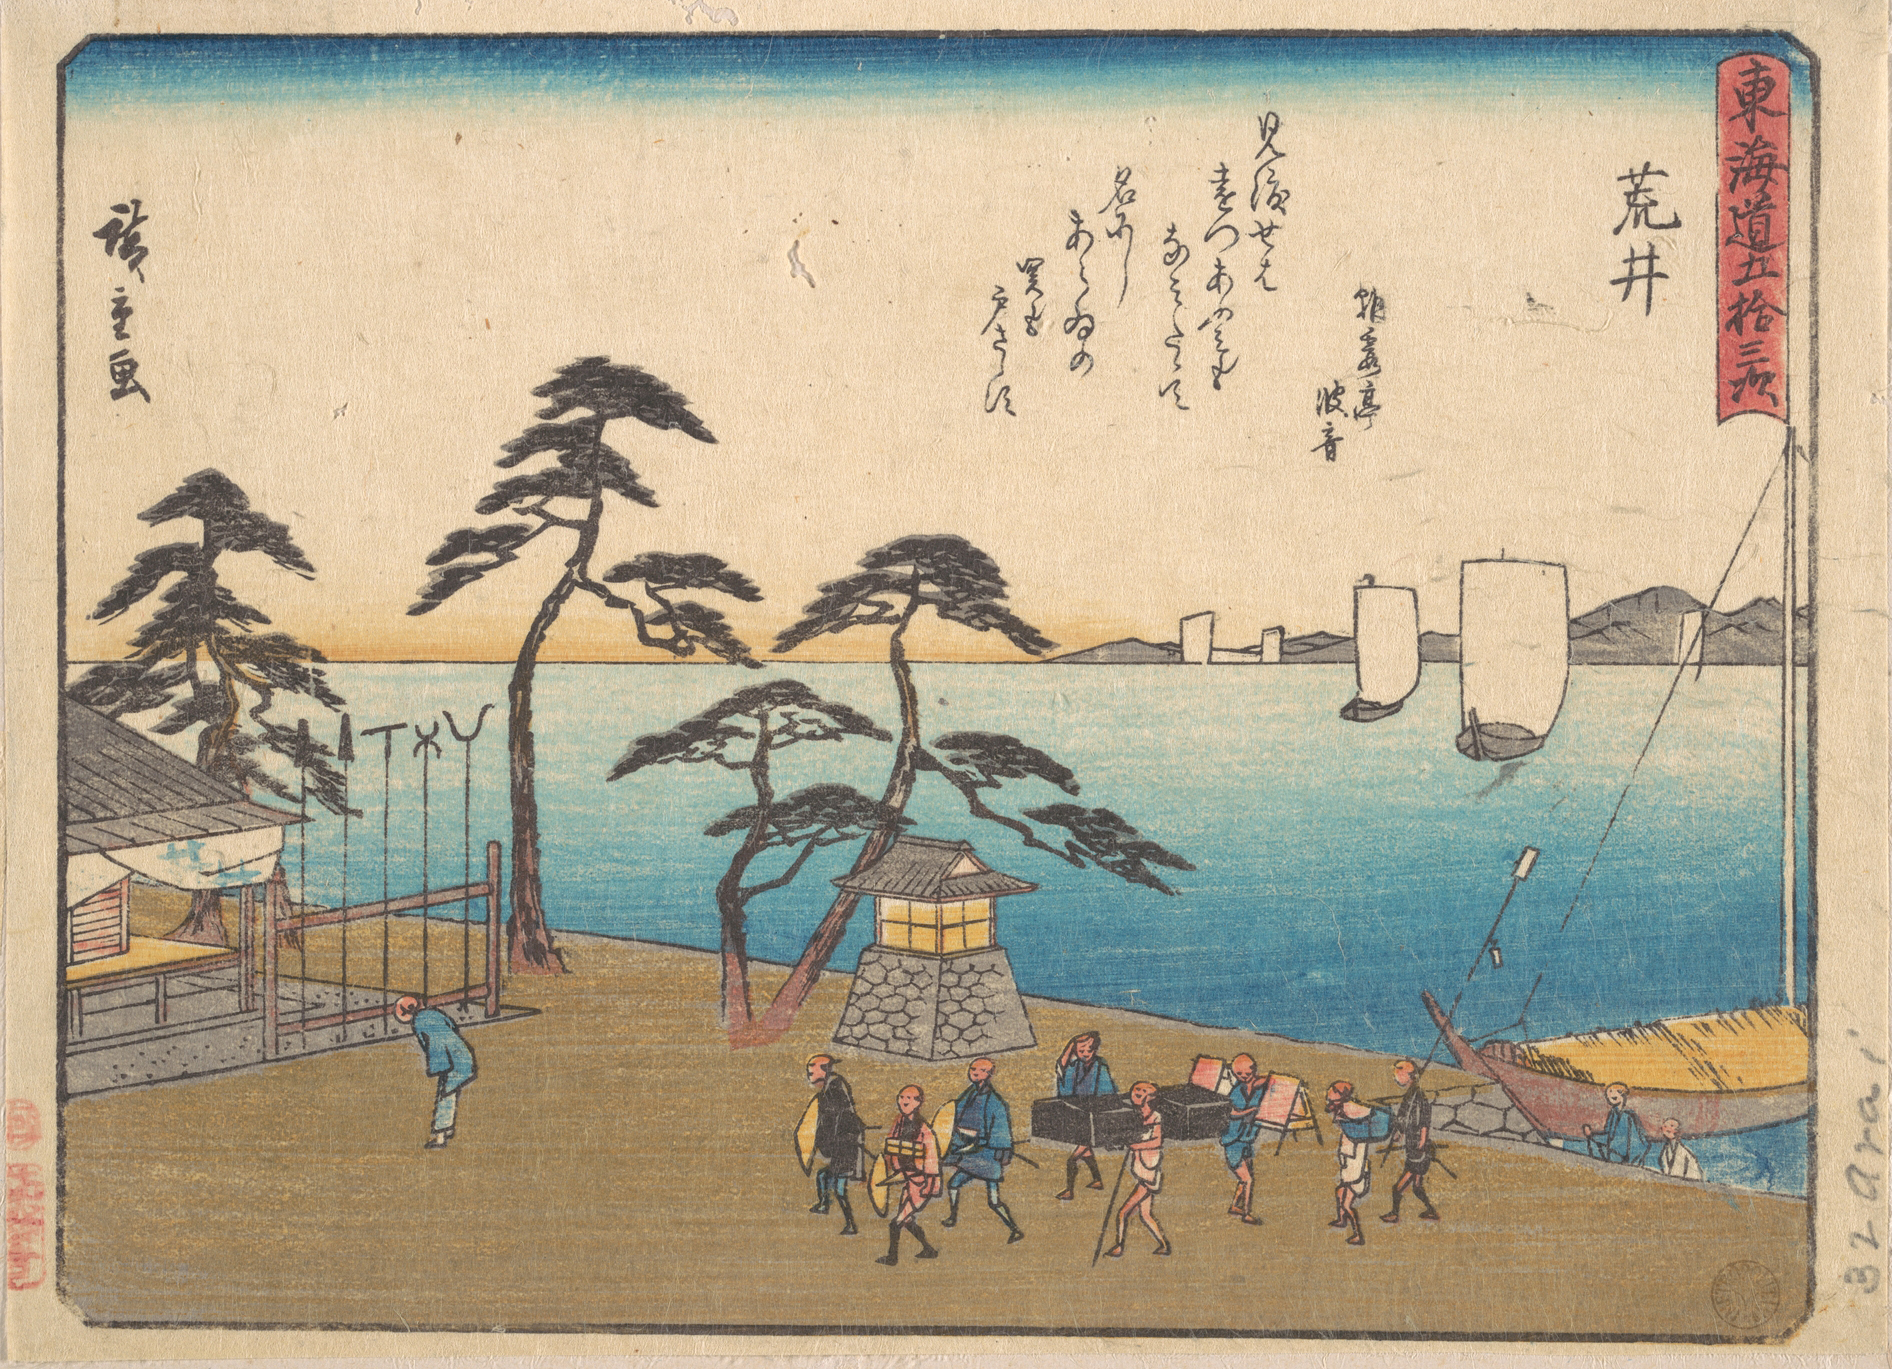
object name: print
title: Arai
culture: japanese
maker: utagawa hiroshige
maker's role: artist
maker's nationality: japanese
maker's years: 1797-1858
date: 1838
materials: ink, paper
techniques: woodblock print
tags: men,boats